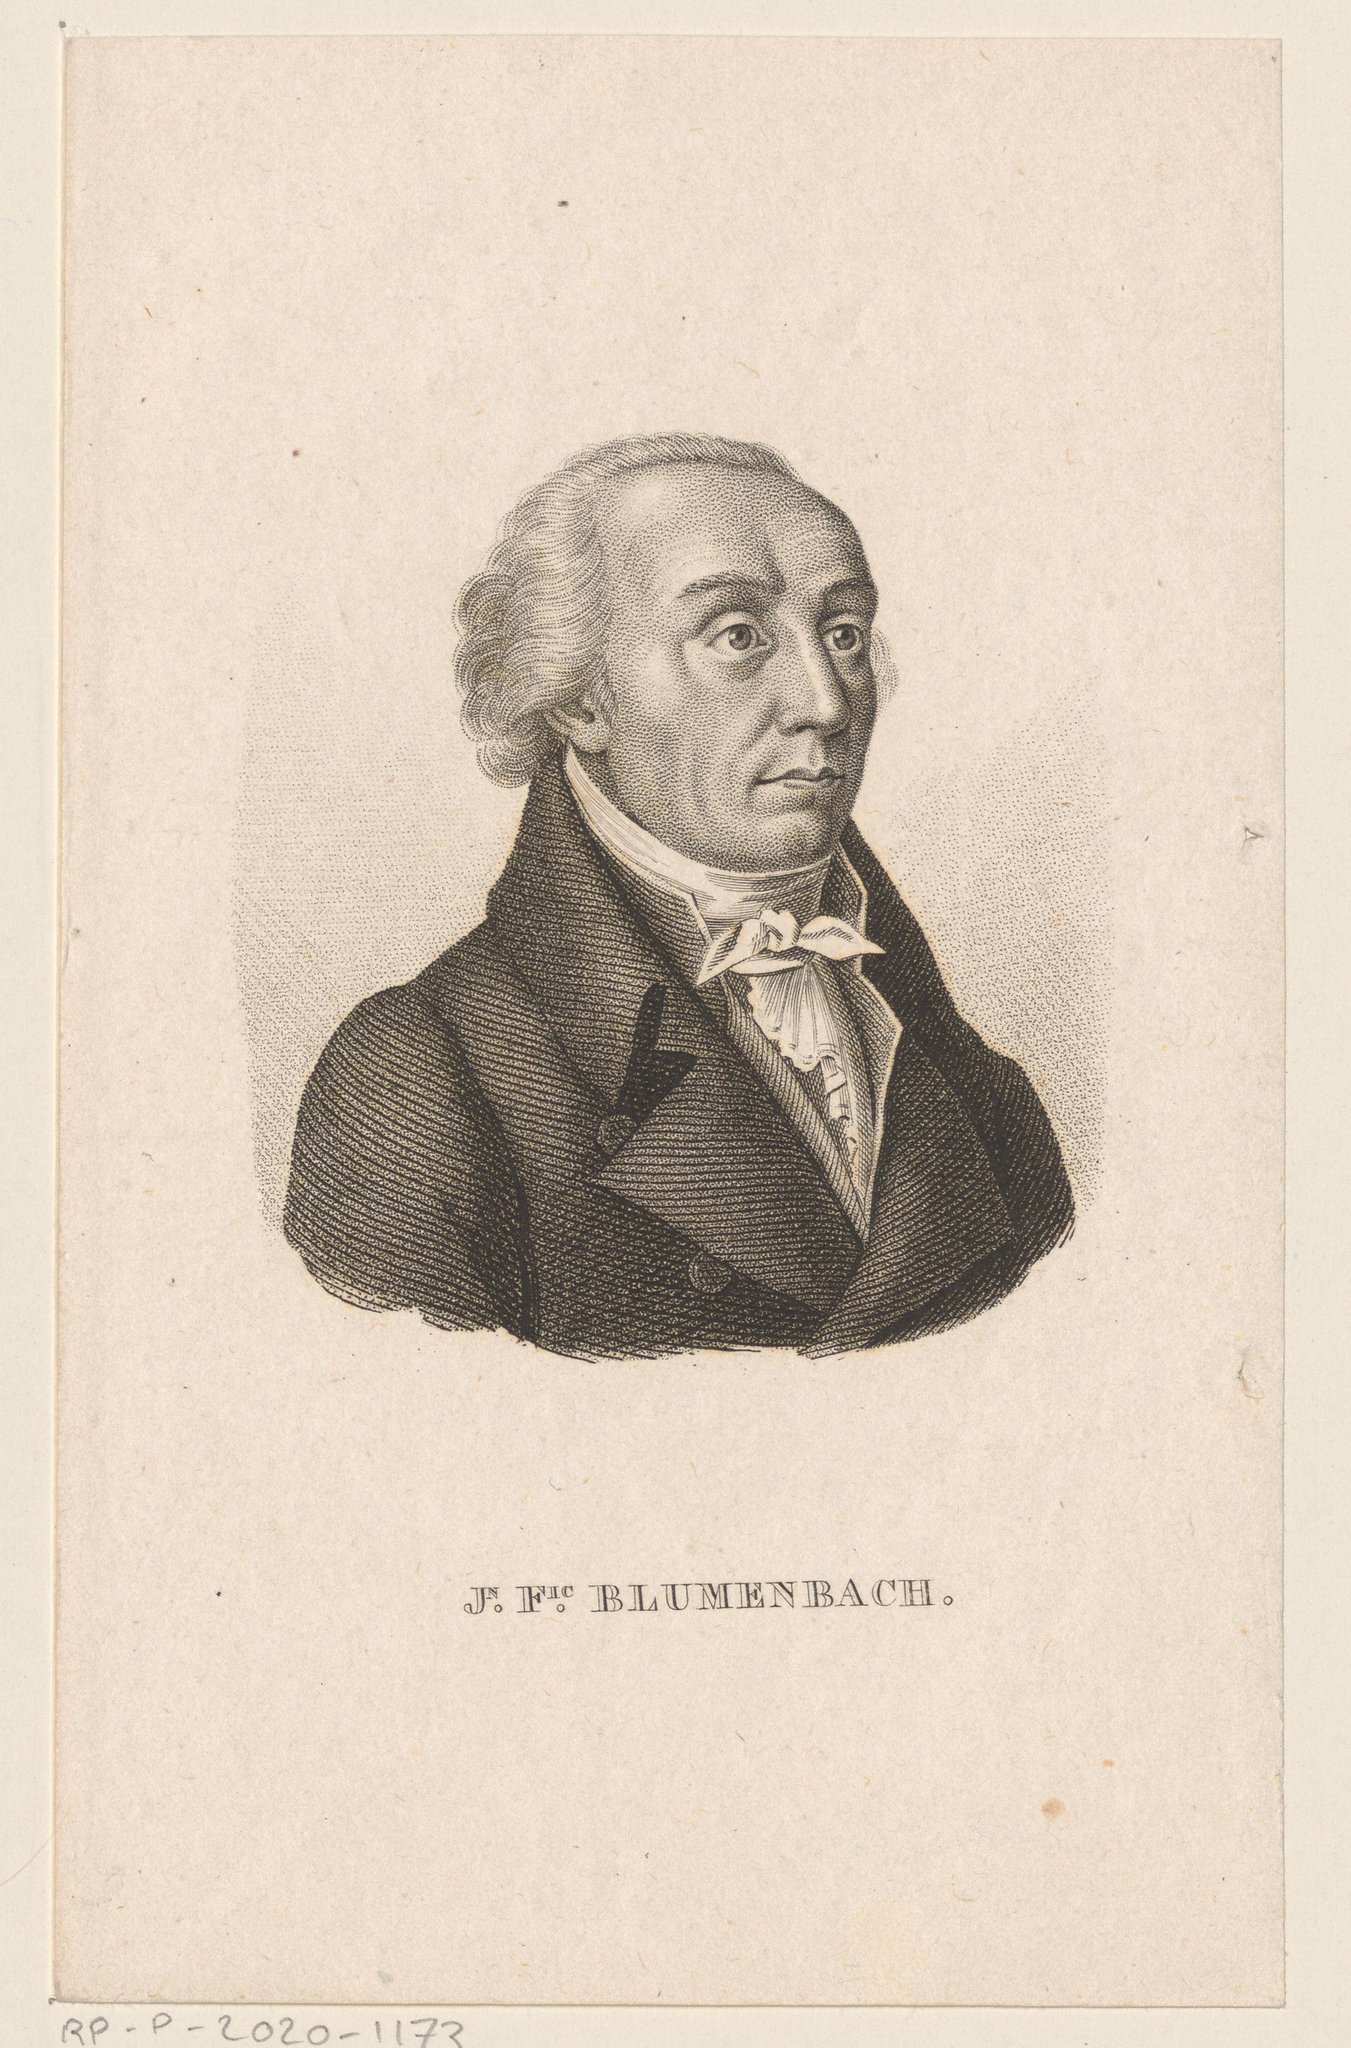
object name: print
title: Portret van Johann Friedrich Blumenbach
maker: Anonymous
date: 1800-1849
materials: paper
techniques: engraving, etching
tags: physicist, historical persons, physician, doctor